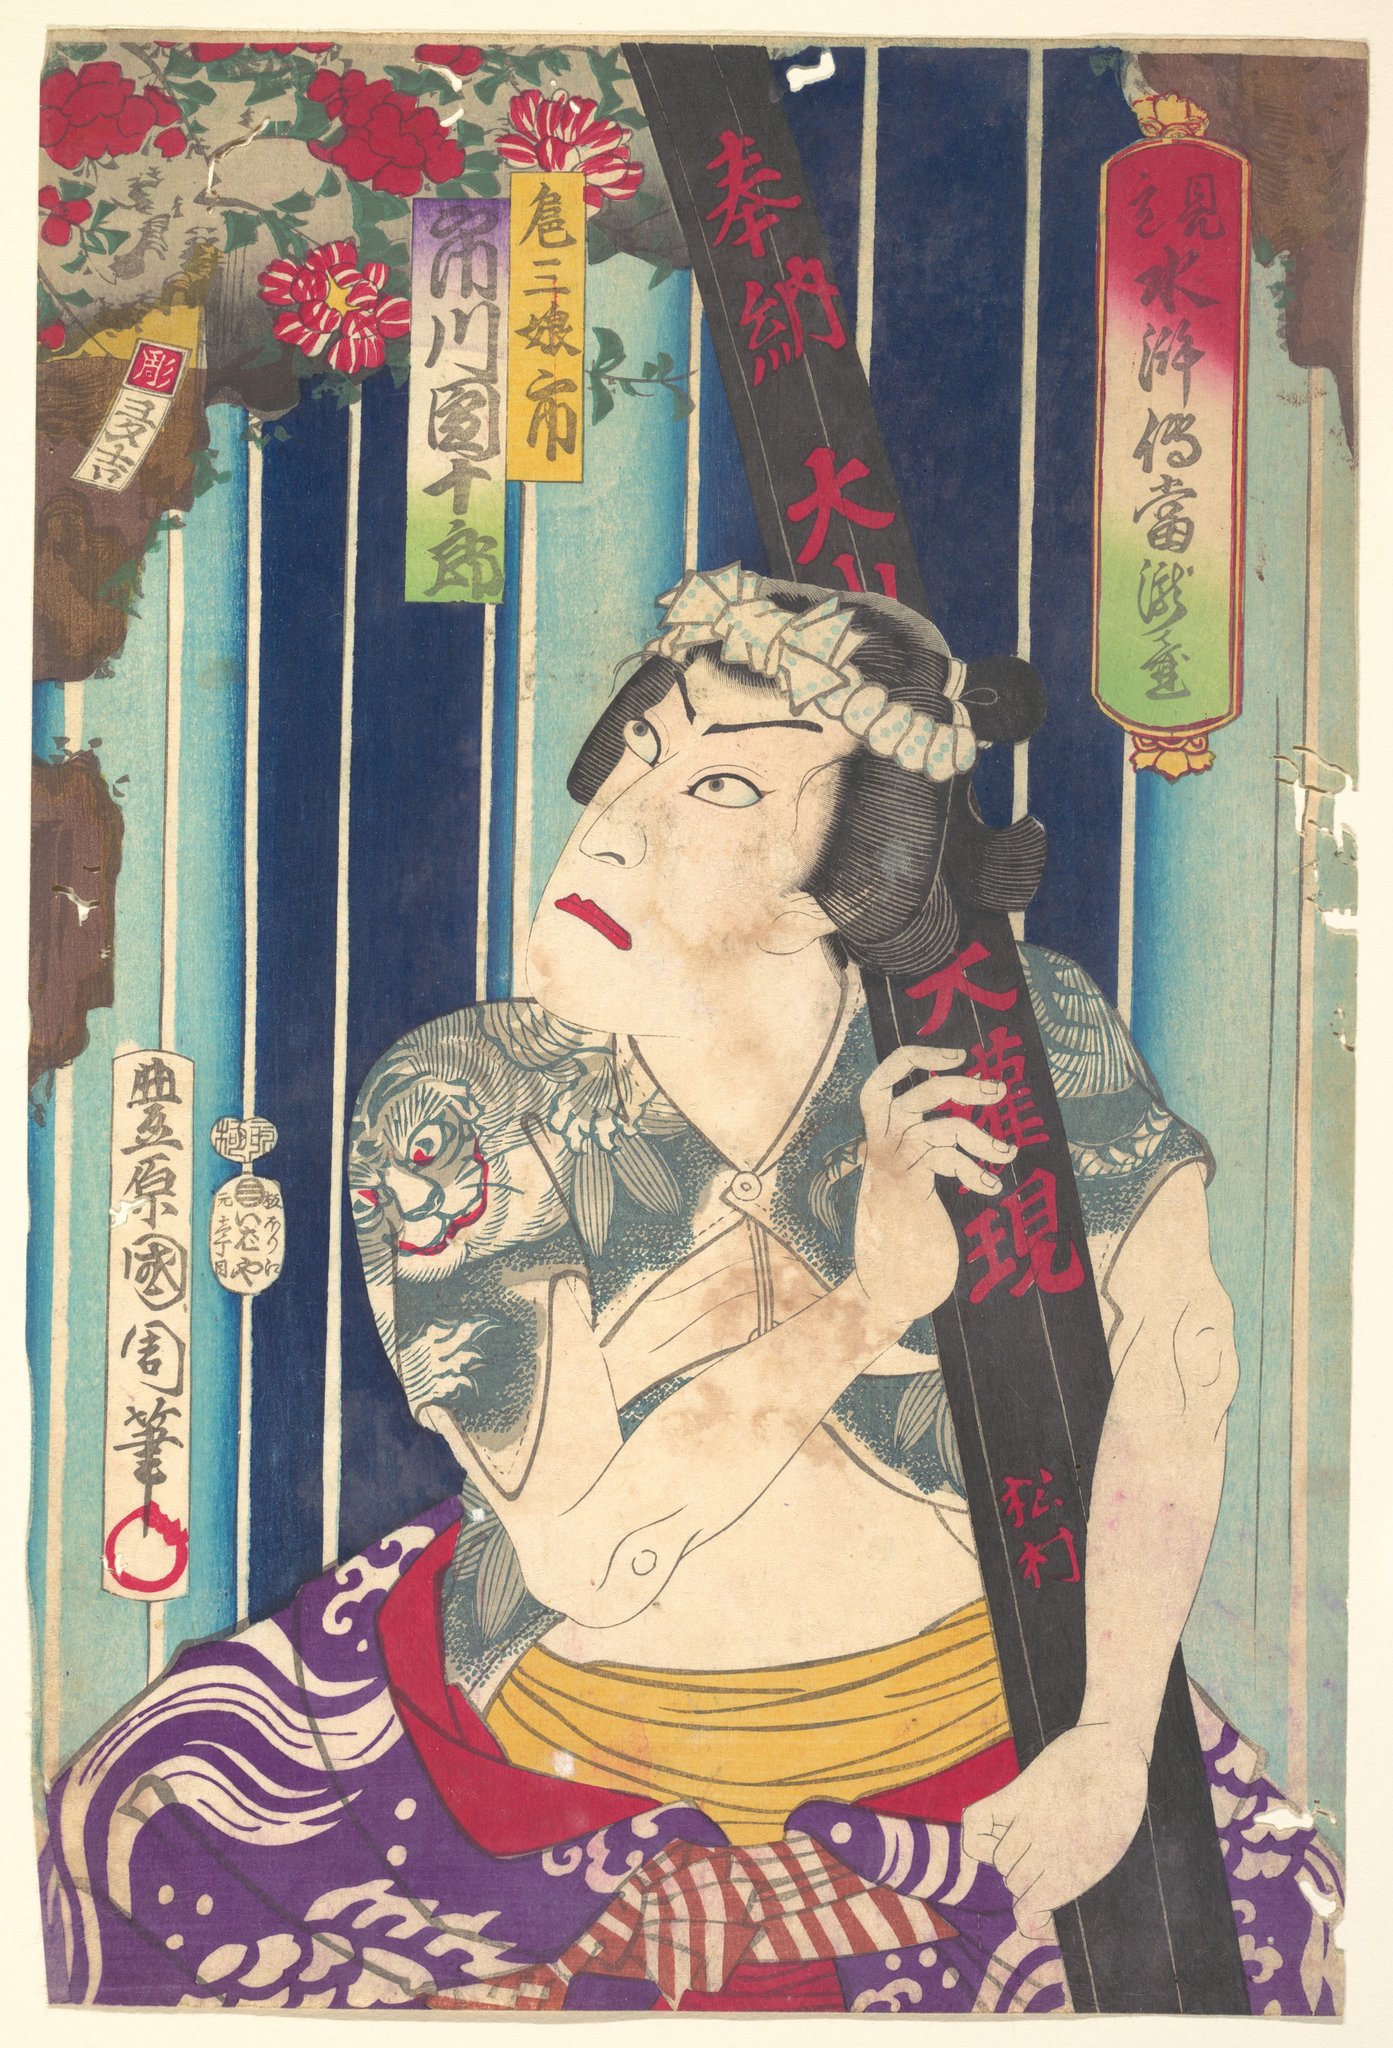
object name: print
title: Imaginary portrait, Shuihuzhuan of Stage: Tōryūdai (Mitate Suikoden Tōrōdai) - Actor, Ichikawa Danjūrō plays as Sanjō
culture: japanese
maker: toyohara kunichika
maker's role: artist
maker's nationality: japanese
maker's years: 1835-1900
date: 1875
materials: ink, paper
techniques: woodblock print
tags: men,actors